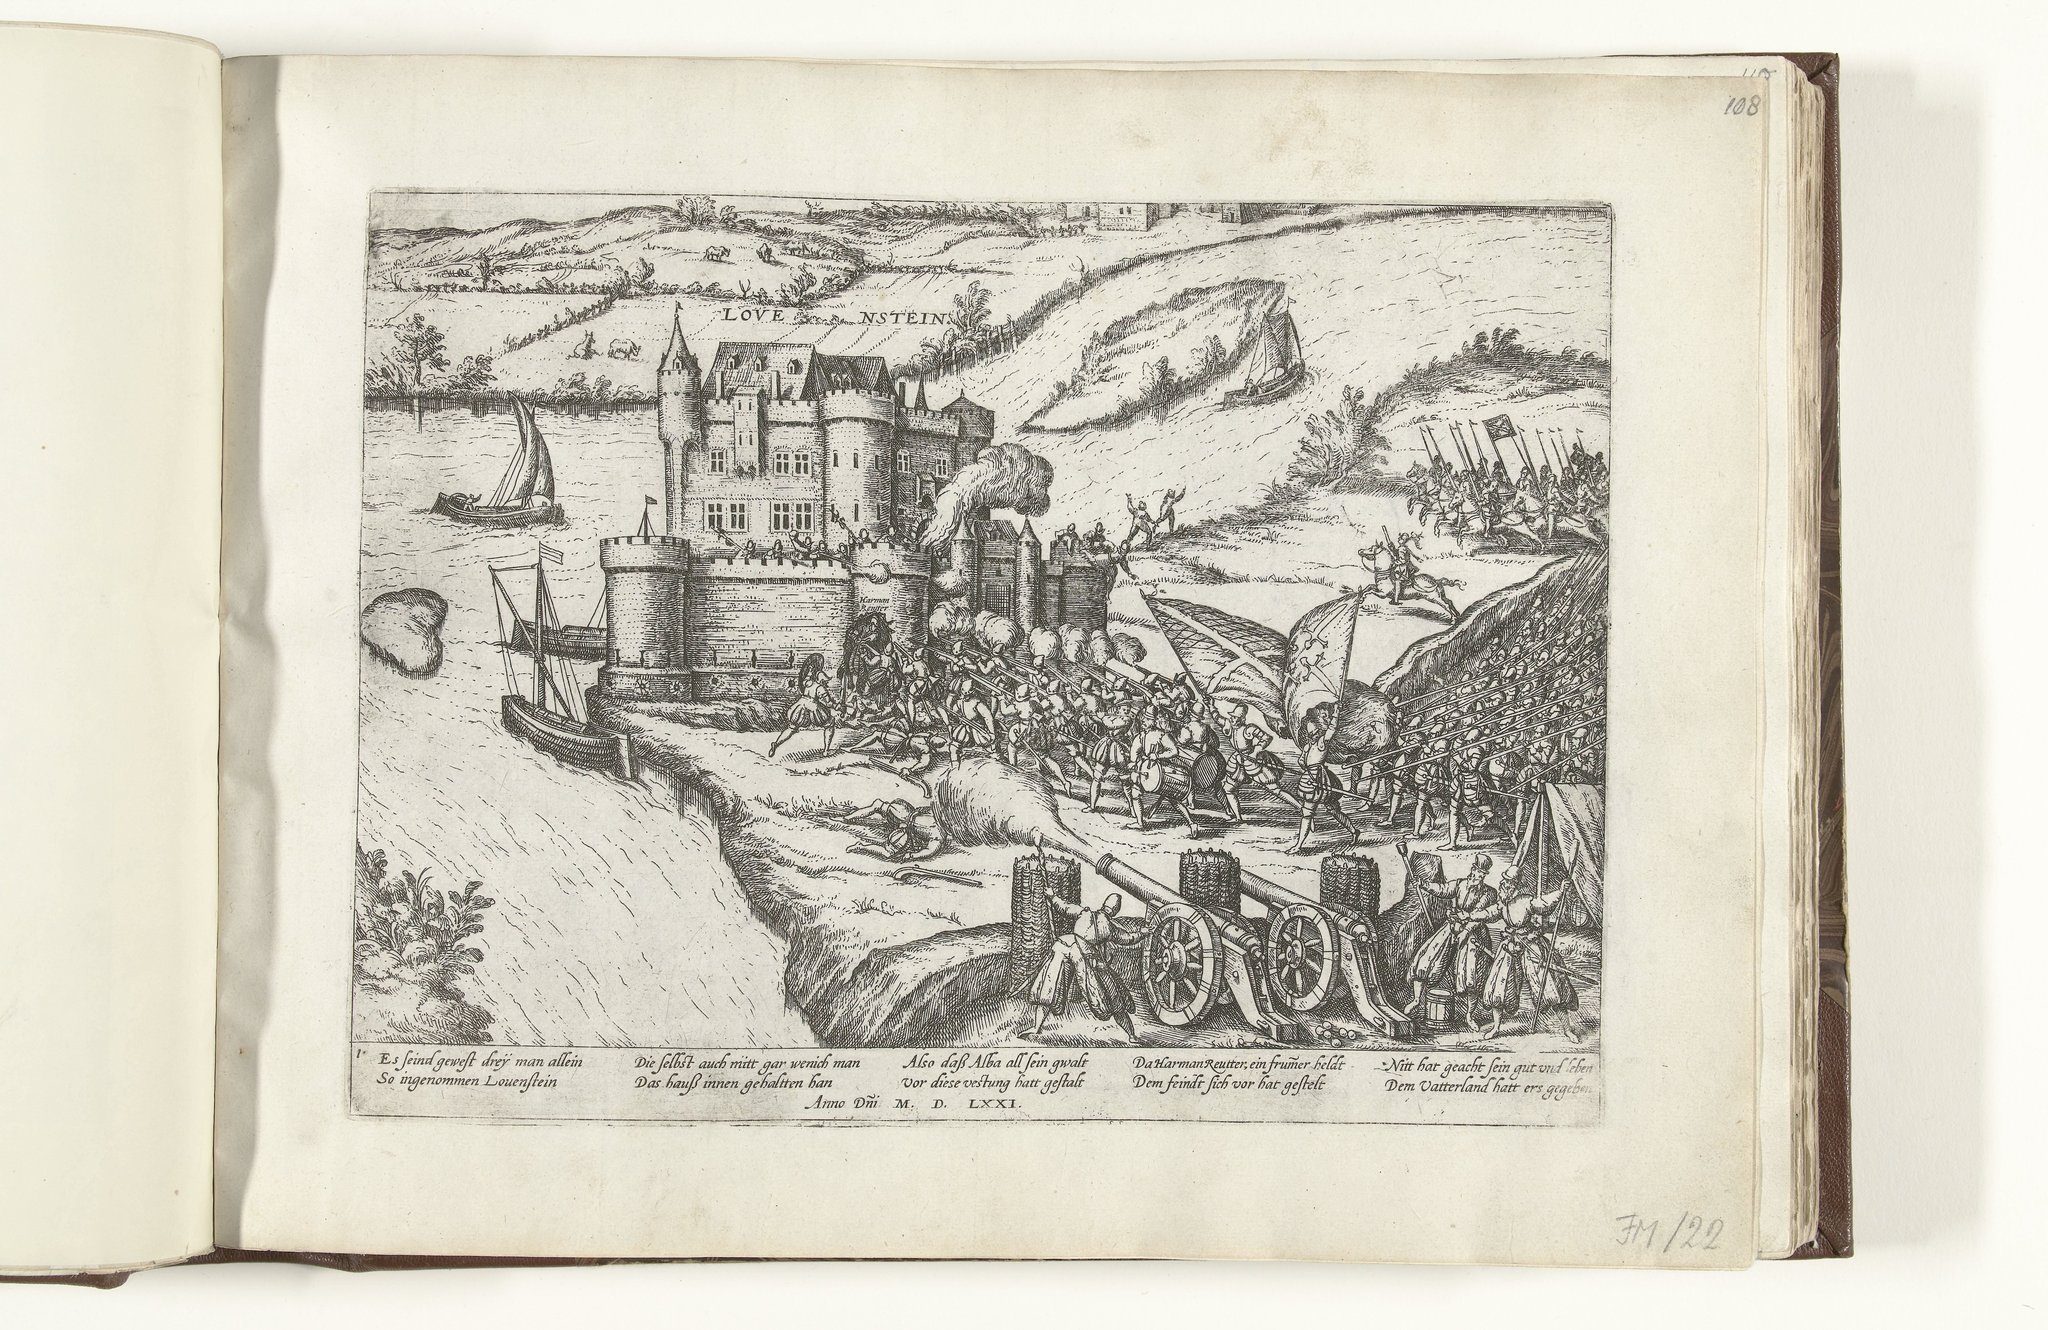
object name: print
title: Slot Loevestein door Herman de Ruiter ingenomen, 1570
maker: frans hogenberg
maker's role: print maker, publisher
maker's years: 1538-1590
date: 1571-1573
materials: paper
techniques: etching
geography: cologne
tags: loevestein castle, siege, position war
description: Slot Loevestein door Herman de Ruiter ingenomen, 9 december 1570 (op de prent vermeld als 1571). Herman de Ruiter weet met een list samen met twee anderen slot Loevestein te veroveren. De voorstelling toont het beleg en de herovering van het slot door de troepen van Alva op 19 december 1570. Met onderschrift van 10 regels in het Duits. Genummerd: 1.